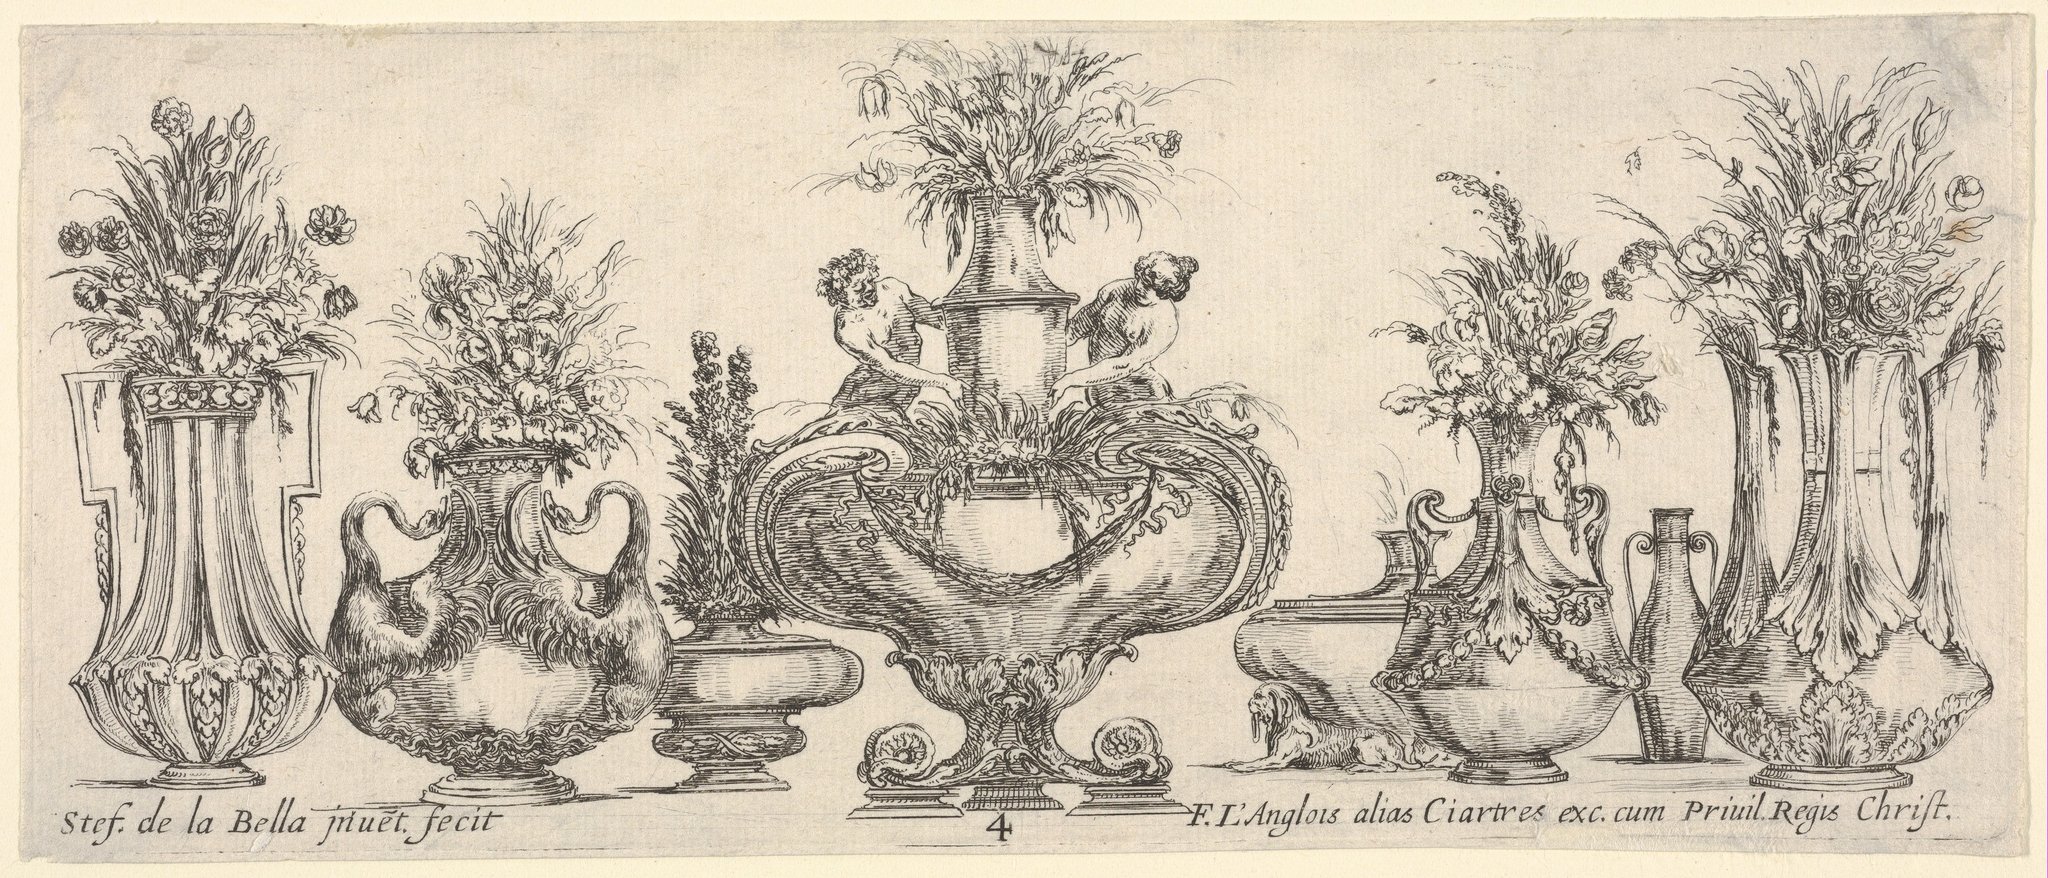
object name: print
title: Eight vases, the largest one in center with sculptures of a nymph and a faun, plate 4 from "Collection of Various Vases" (Raccolta di Vasi Diversi)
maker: stefano della bella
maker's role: artist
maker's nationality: italian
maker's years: 1610-1664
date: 1650-1656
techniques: etching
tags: nymphs,fauns,vases